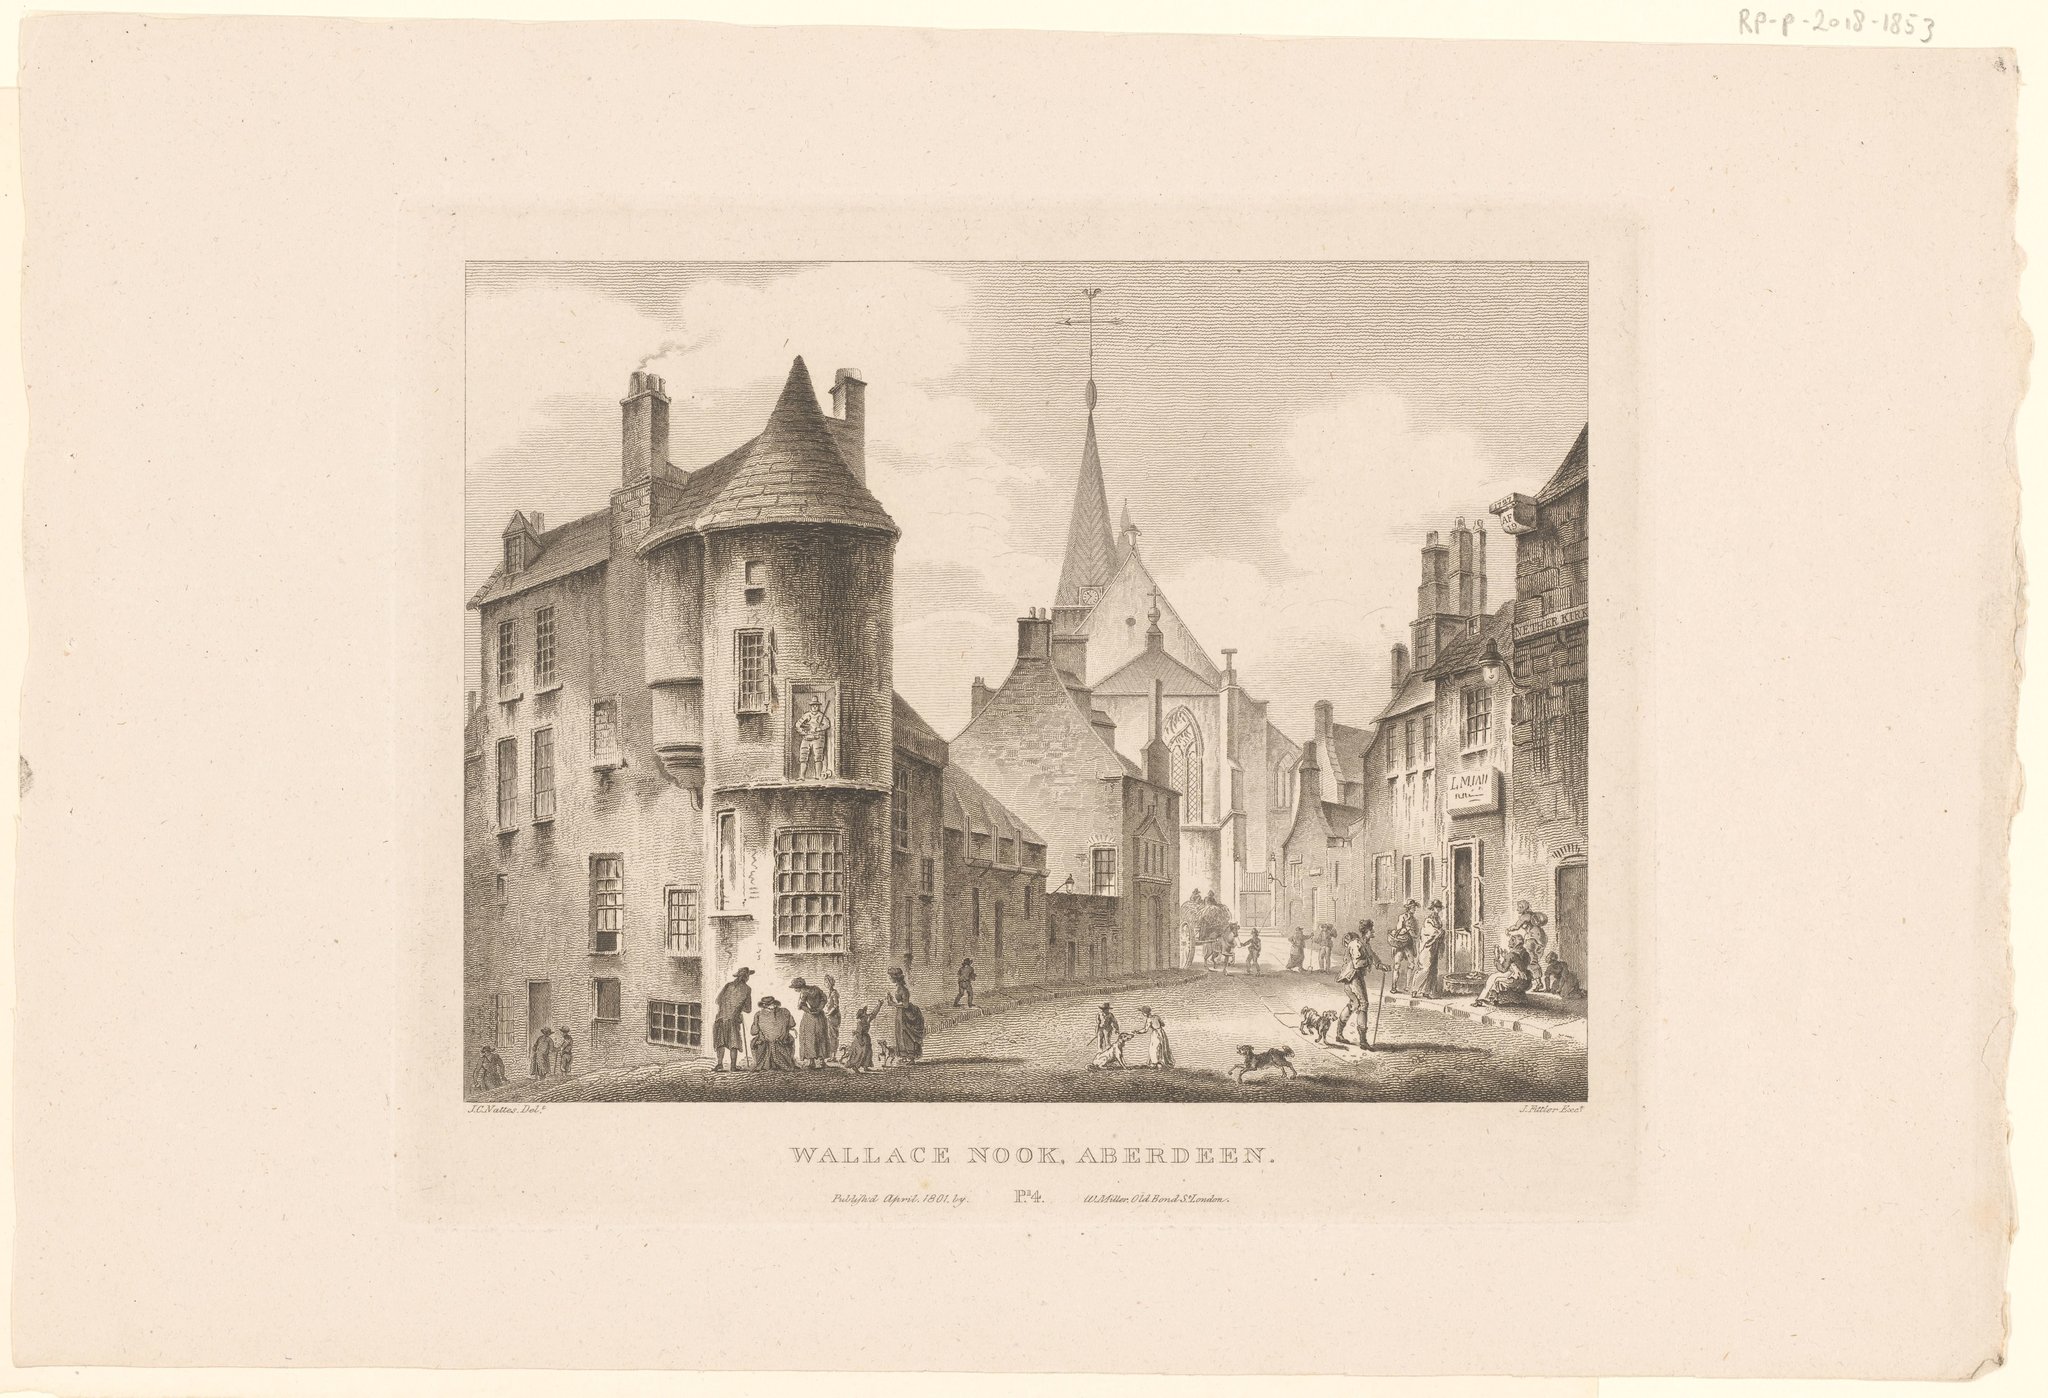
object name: print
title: Gezicht op een straat in Aberdeen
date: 1801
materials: paper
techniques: etching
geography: london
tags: street (+ city(-scape) with figures, staffage)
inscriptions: collector's mark: Lugt 2228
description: Prent gebruikt in: Scotia Depicta; or the antiquities, castles, public buildings, noblemen (...). Londen: William Miller, 1801. Zie ook: RP-P-2018-1854.